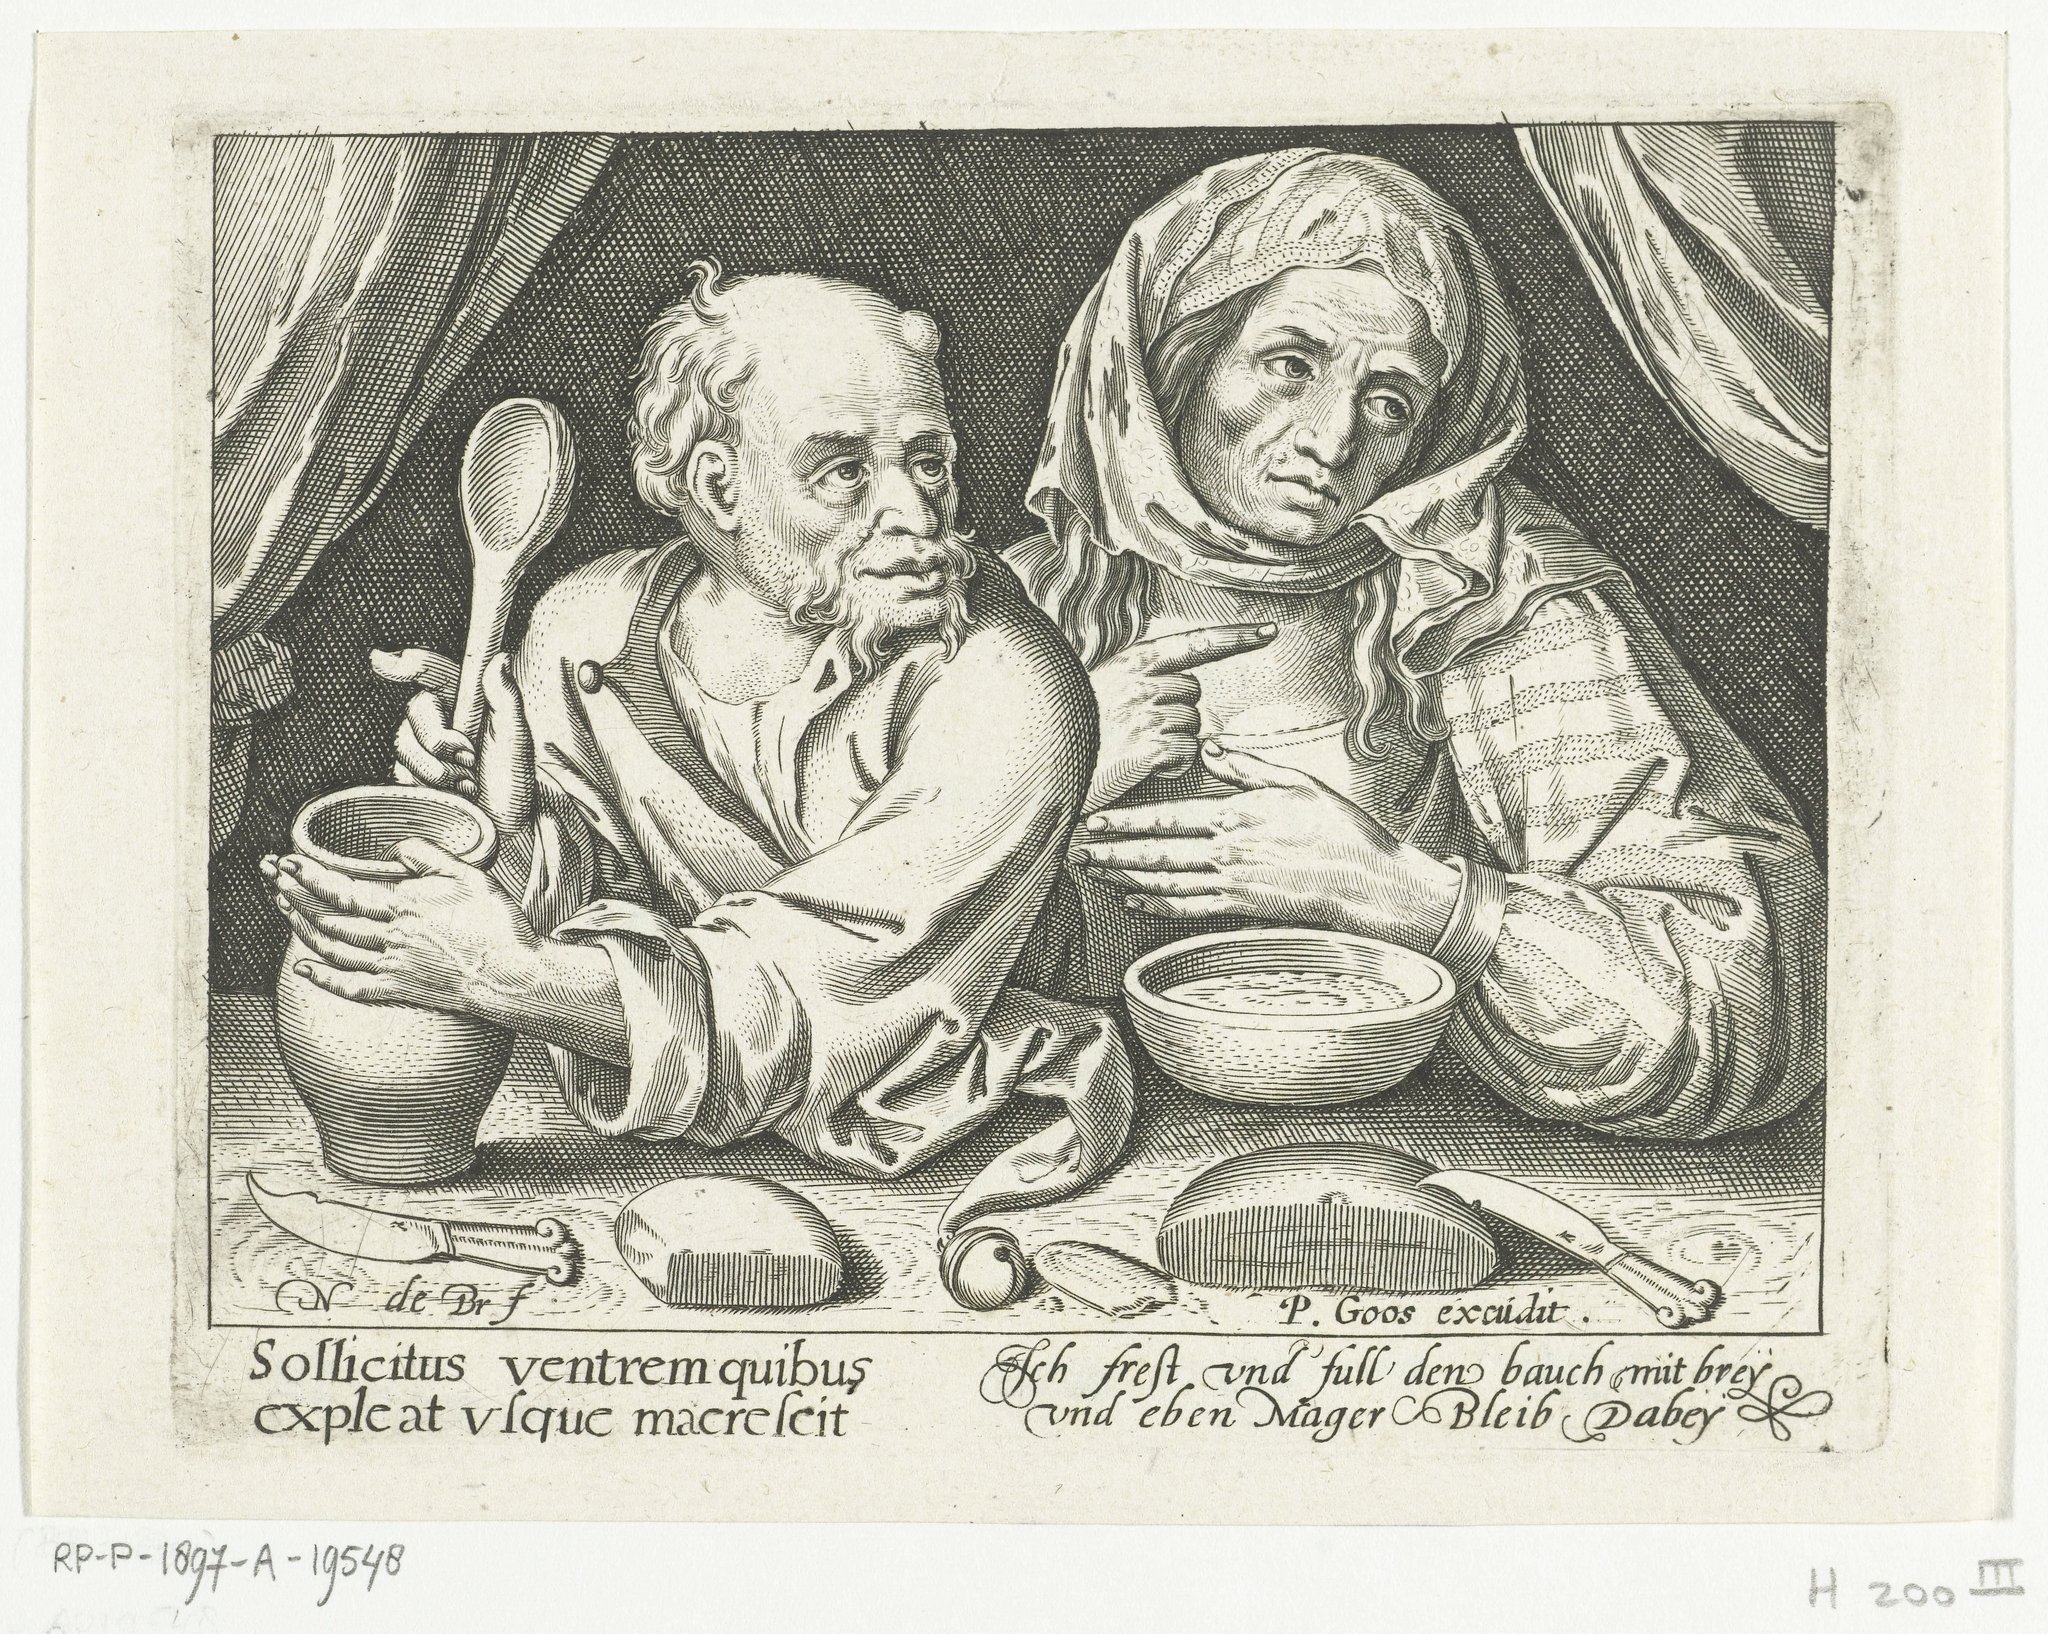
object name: print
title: Man en vrouw eten pap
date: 1581-1656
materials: paper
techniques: engraving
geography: netherlands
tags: cereal, eating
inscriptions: collector's mark: Lugt 2228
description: Man en vrouw zitten aan tafel en eten pap. Het Duitse vers in de marge onder zinspeelt op het eten van de voedzame pap waar een mens mager bij blijft.